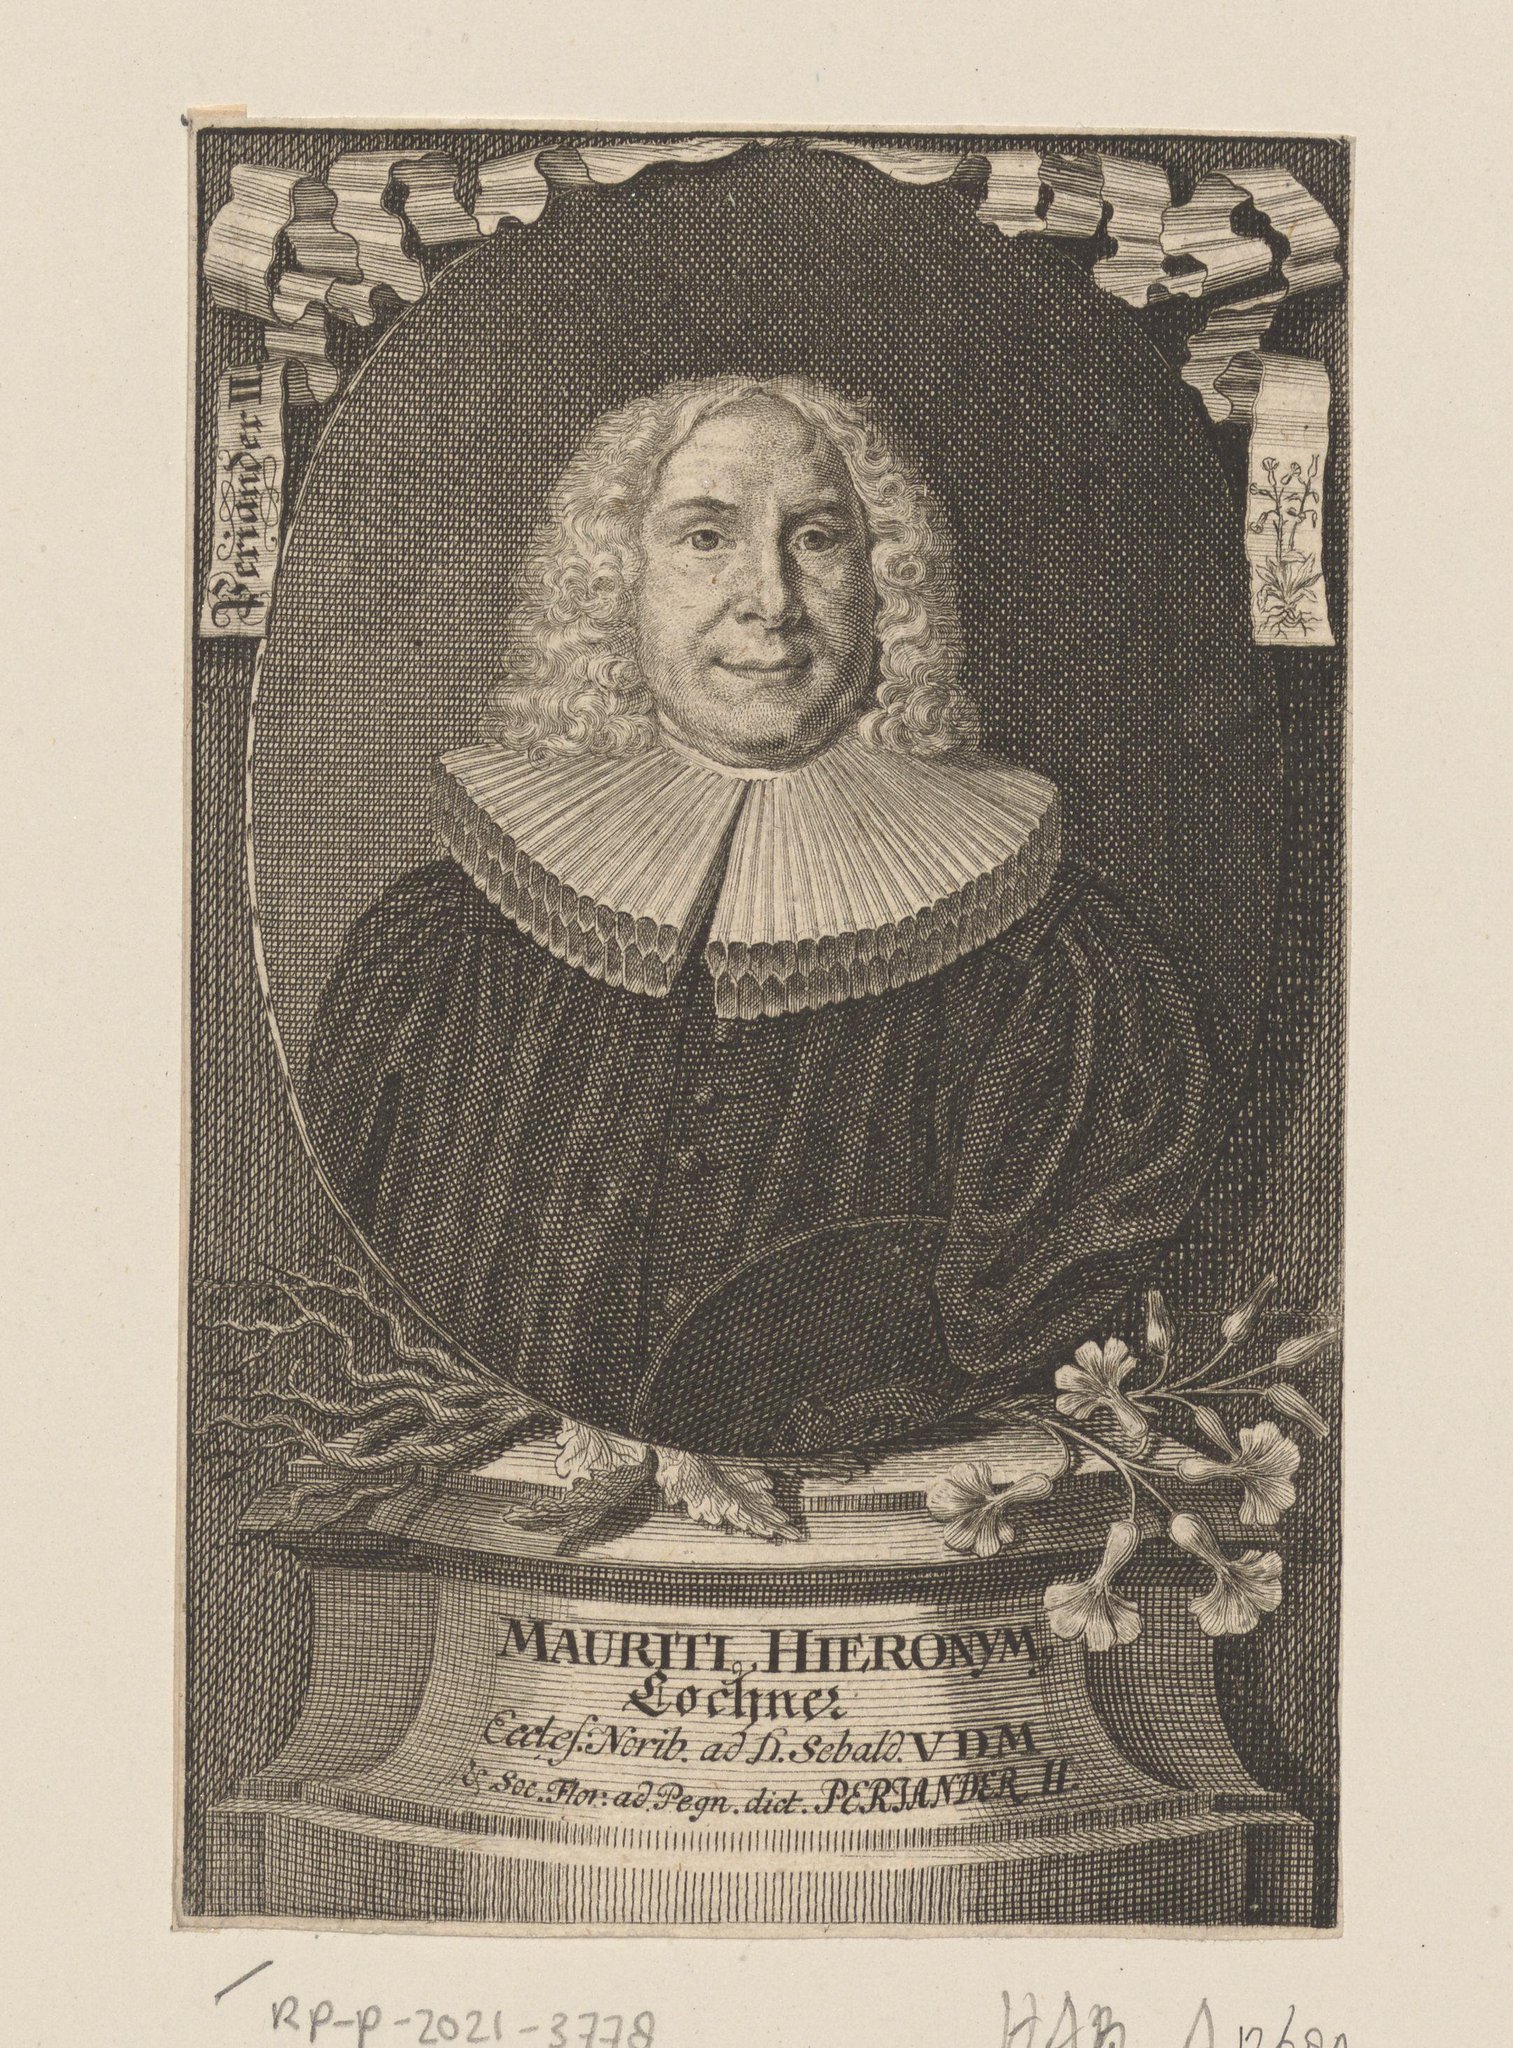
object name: book illustration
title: Portret van Moritz Hieronymus Lochner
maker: Anonymous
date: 1727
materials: paper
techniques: engraving, etching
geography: germany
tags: theologian, ornament ~ medallion, historical persons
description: Prent waarschijnlijk uit: Fränckische acta erudita et curiosa (...). Neurenberg: Julius Arnold Engelbrecht, 1727, dl. 7.